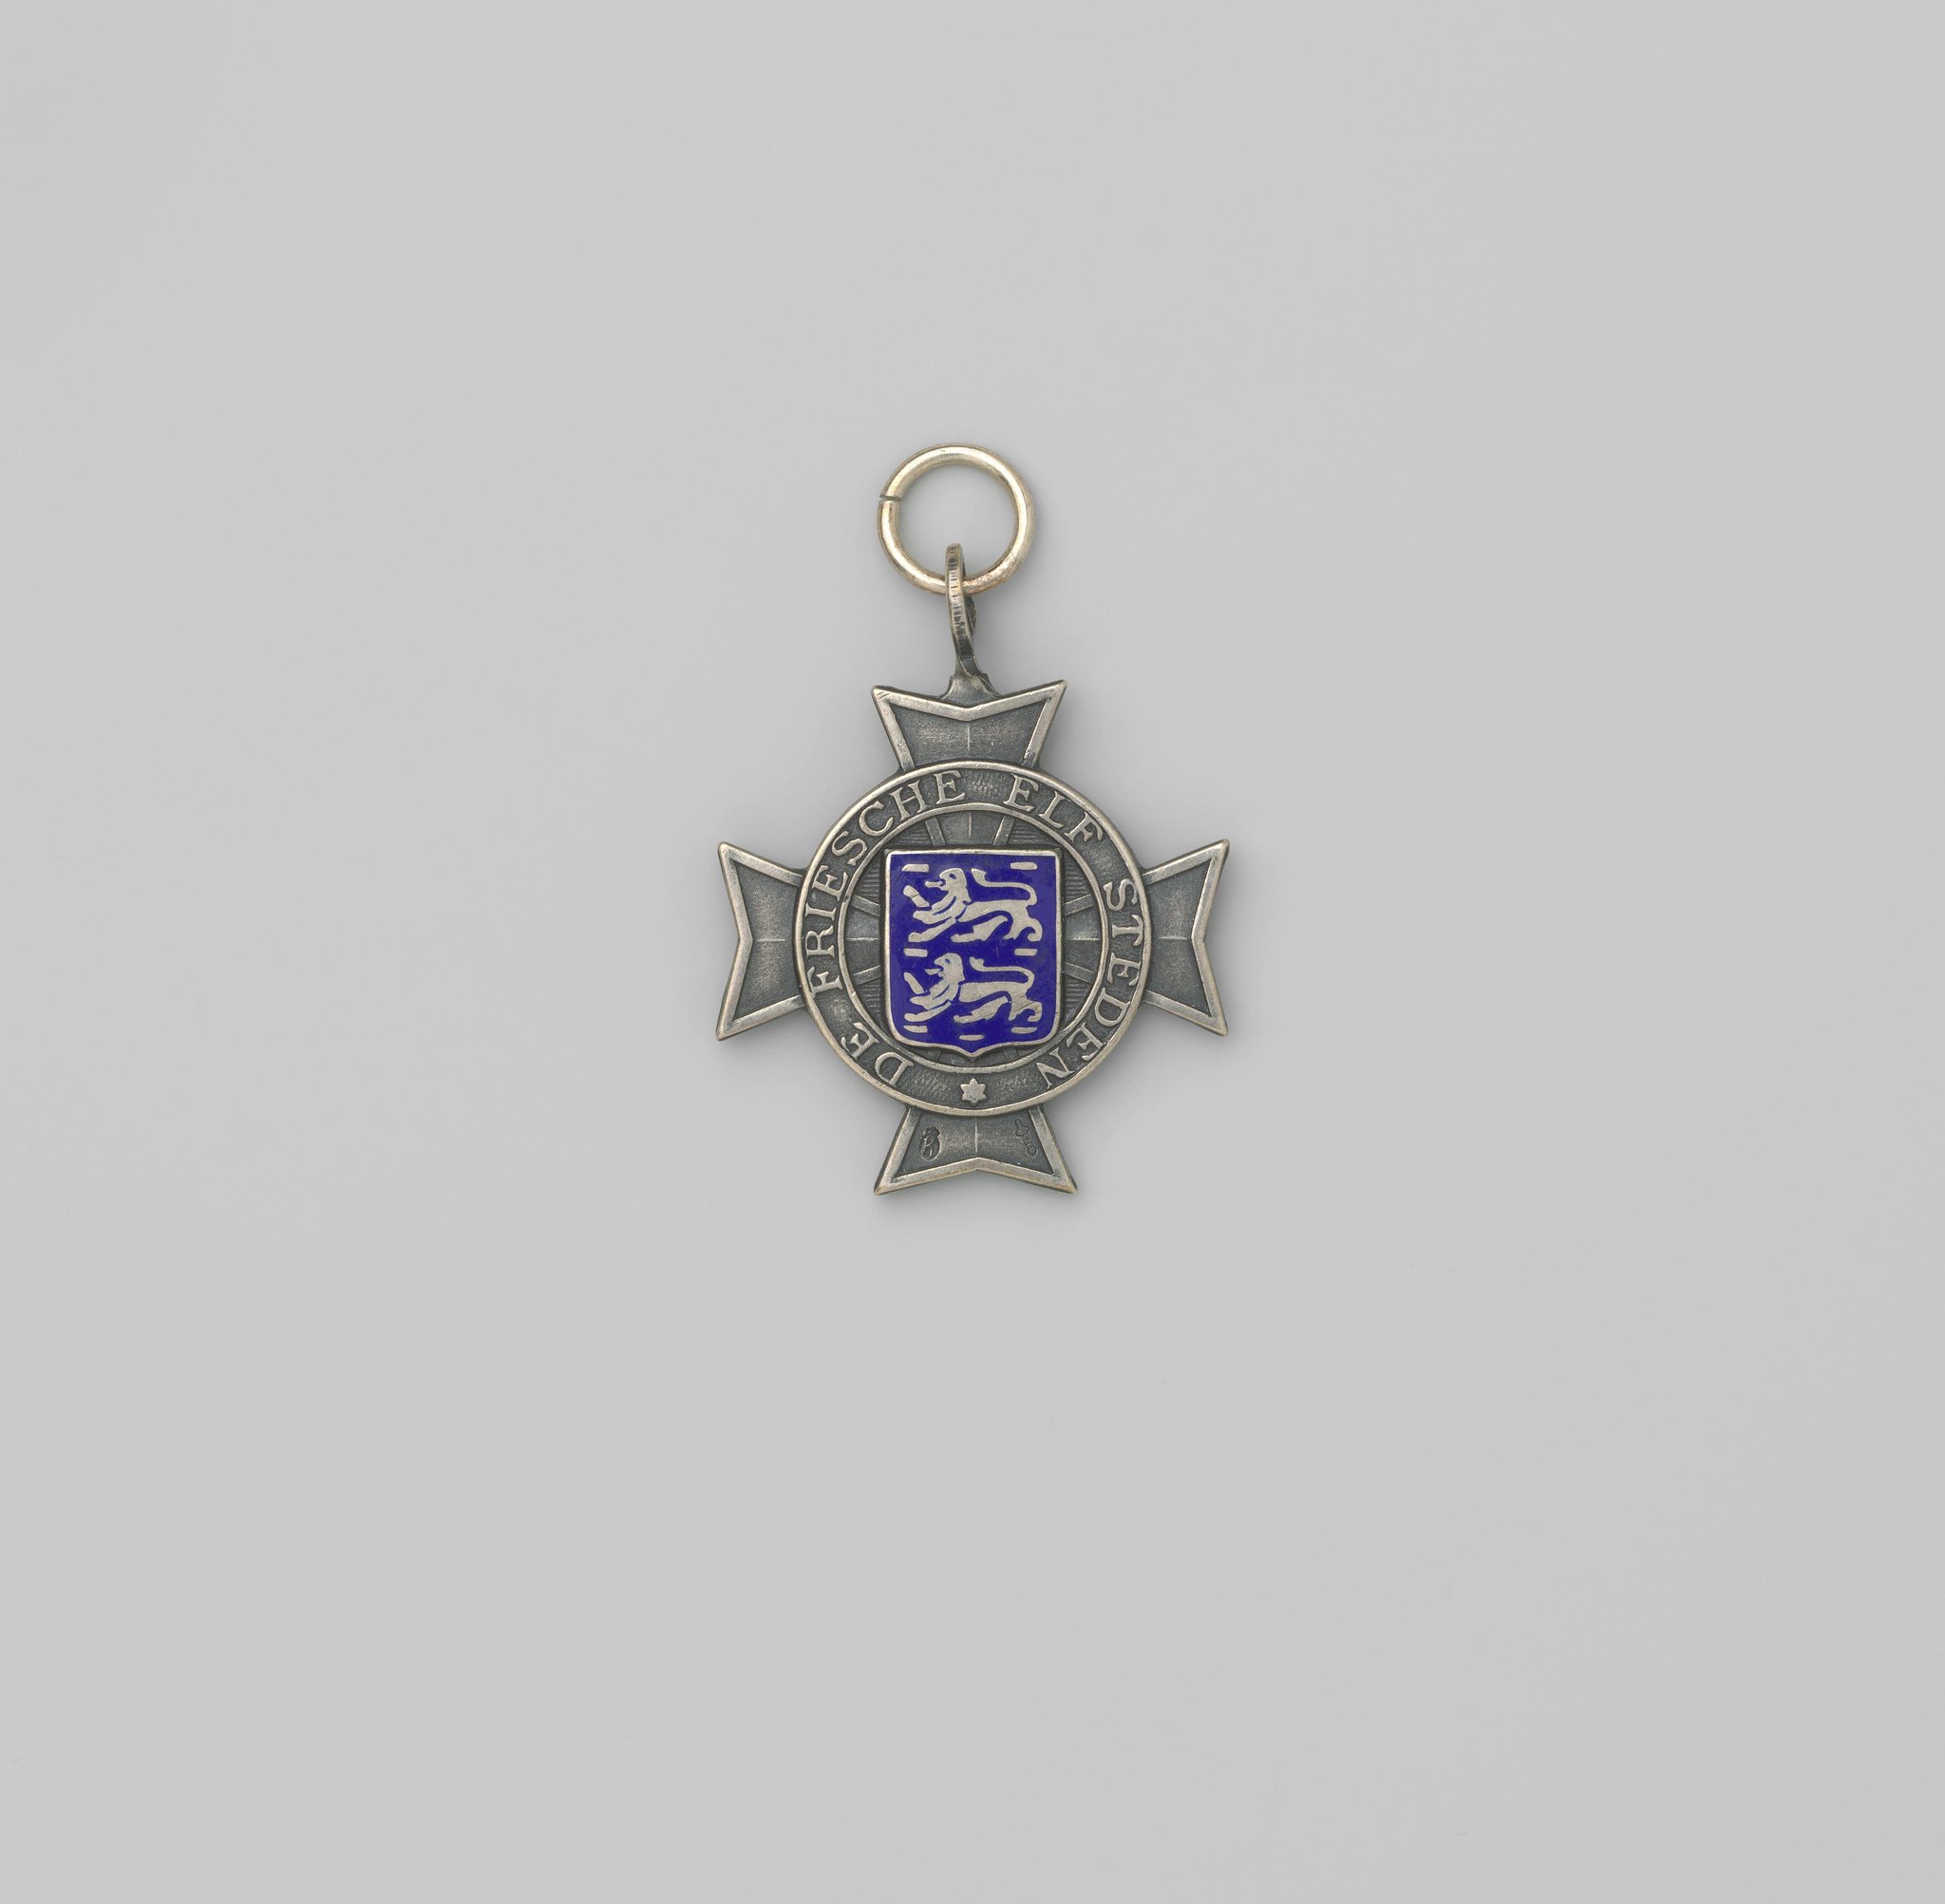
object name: onderscheidingsteken, onderscheiding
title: Het Elfstedenkruisje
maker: pim mulier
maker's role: designer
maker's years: 1865-1954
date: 1909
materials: metal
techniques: striking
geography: voorschoten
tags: eleven cities tour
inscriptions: inscription: ‘21 FEBR. 1985’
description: Maltezerkruis waarbinnen band met tekst 'De Friesche Elf Steden', waarbinnen blauw geemailleerd wapen (van Friesland) met boven elkaar twee naar links lopende leeuwen, met draagoog waaraan ringetje; keerzijde: in cirkel datum '21 FEBR. 1985'.